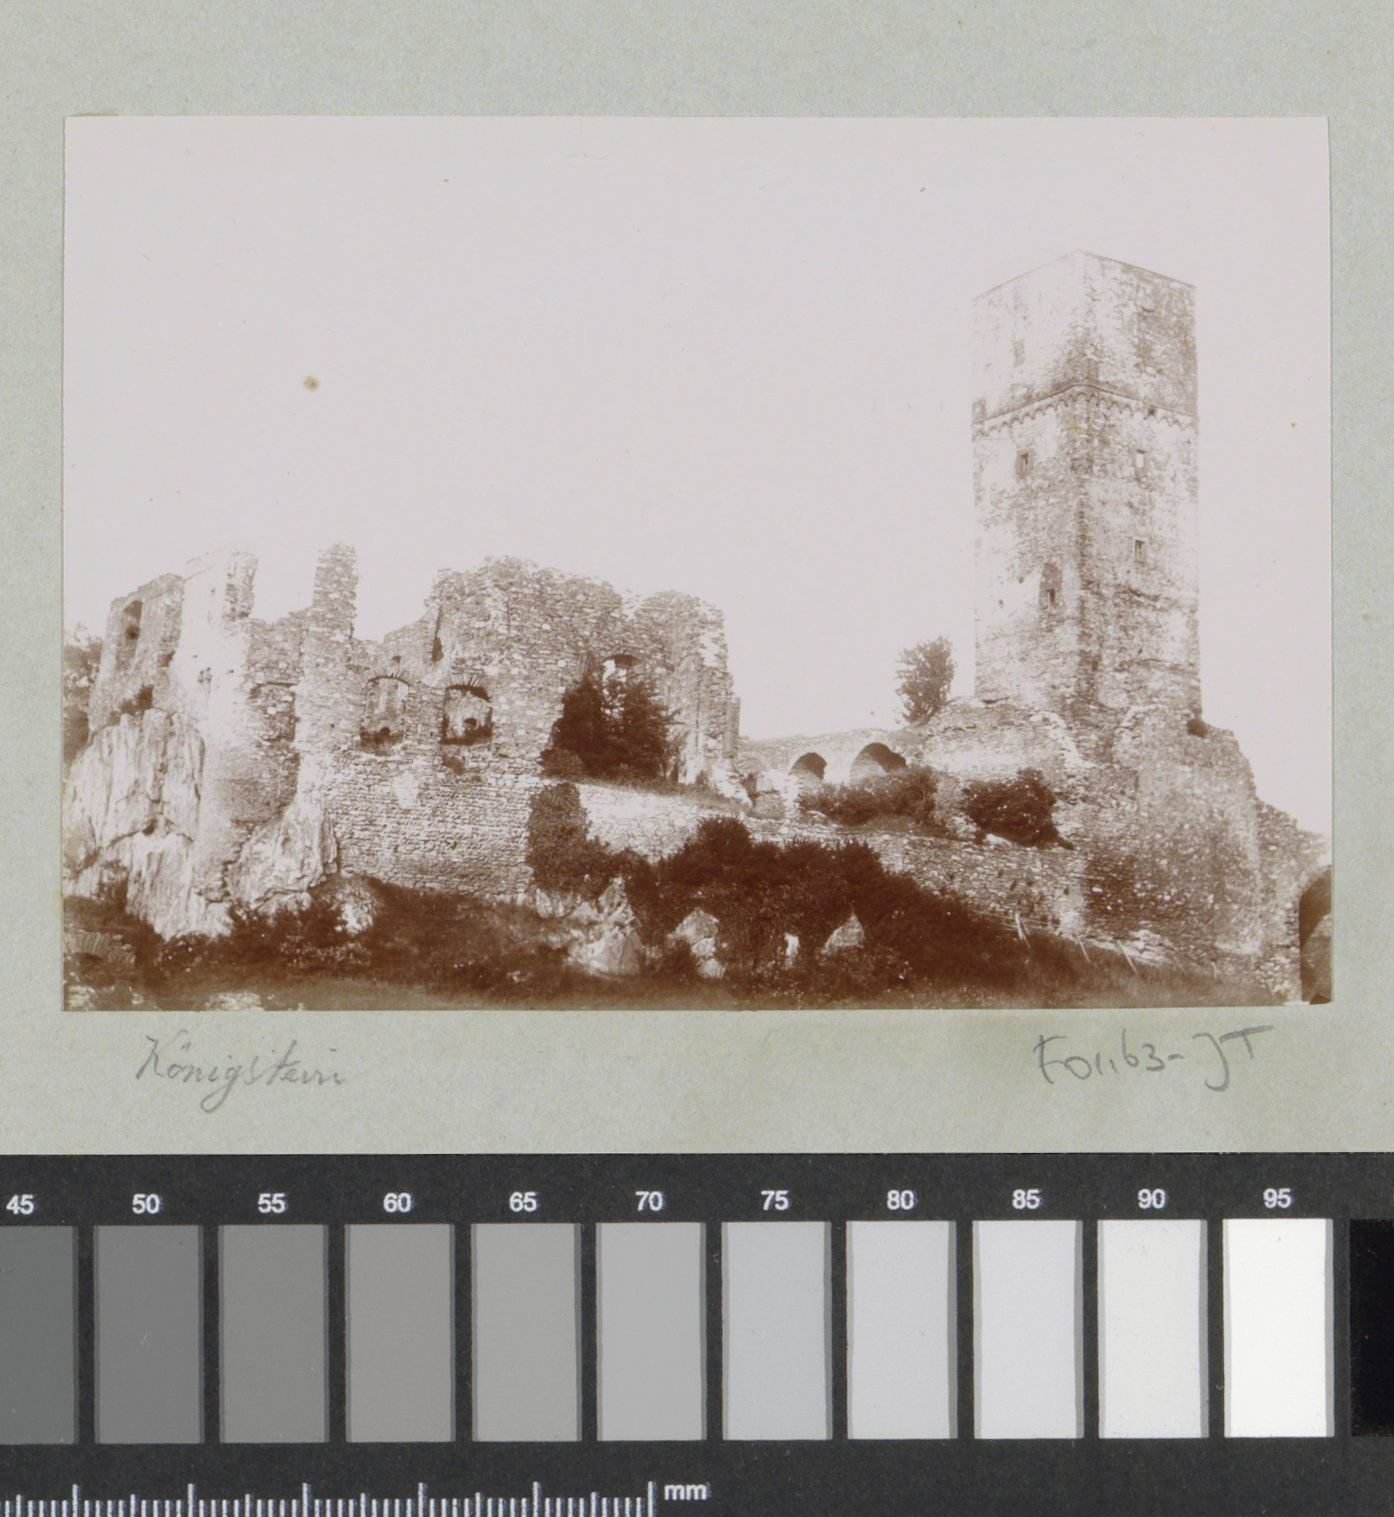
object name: photograph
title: Gezicht op de ruïne van kasteel Königstein im Taunus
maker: delizy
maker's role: manufacturer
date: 1900-1906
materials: paper, photographic support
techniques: gelatin silver print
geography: königstein im taunus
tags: ruin of a dwelling, house, castle, etc.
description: Onderdeel van Fotoalbum van een Franse amateurfotograaf met opnames van uitstapjes in Frankrijk, Spanje, België, Luxemburg en Nederland, de eerste automobielen en autoraces.